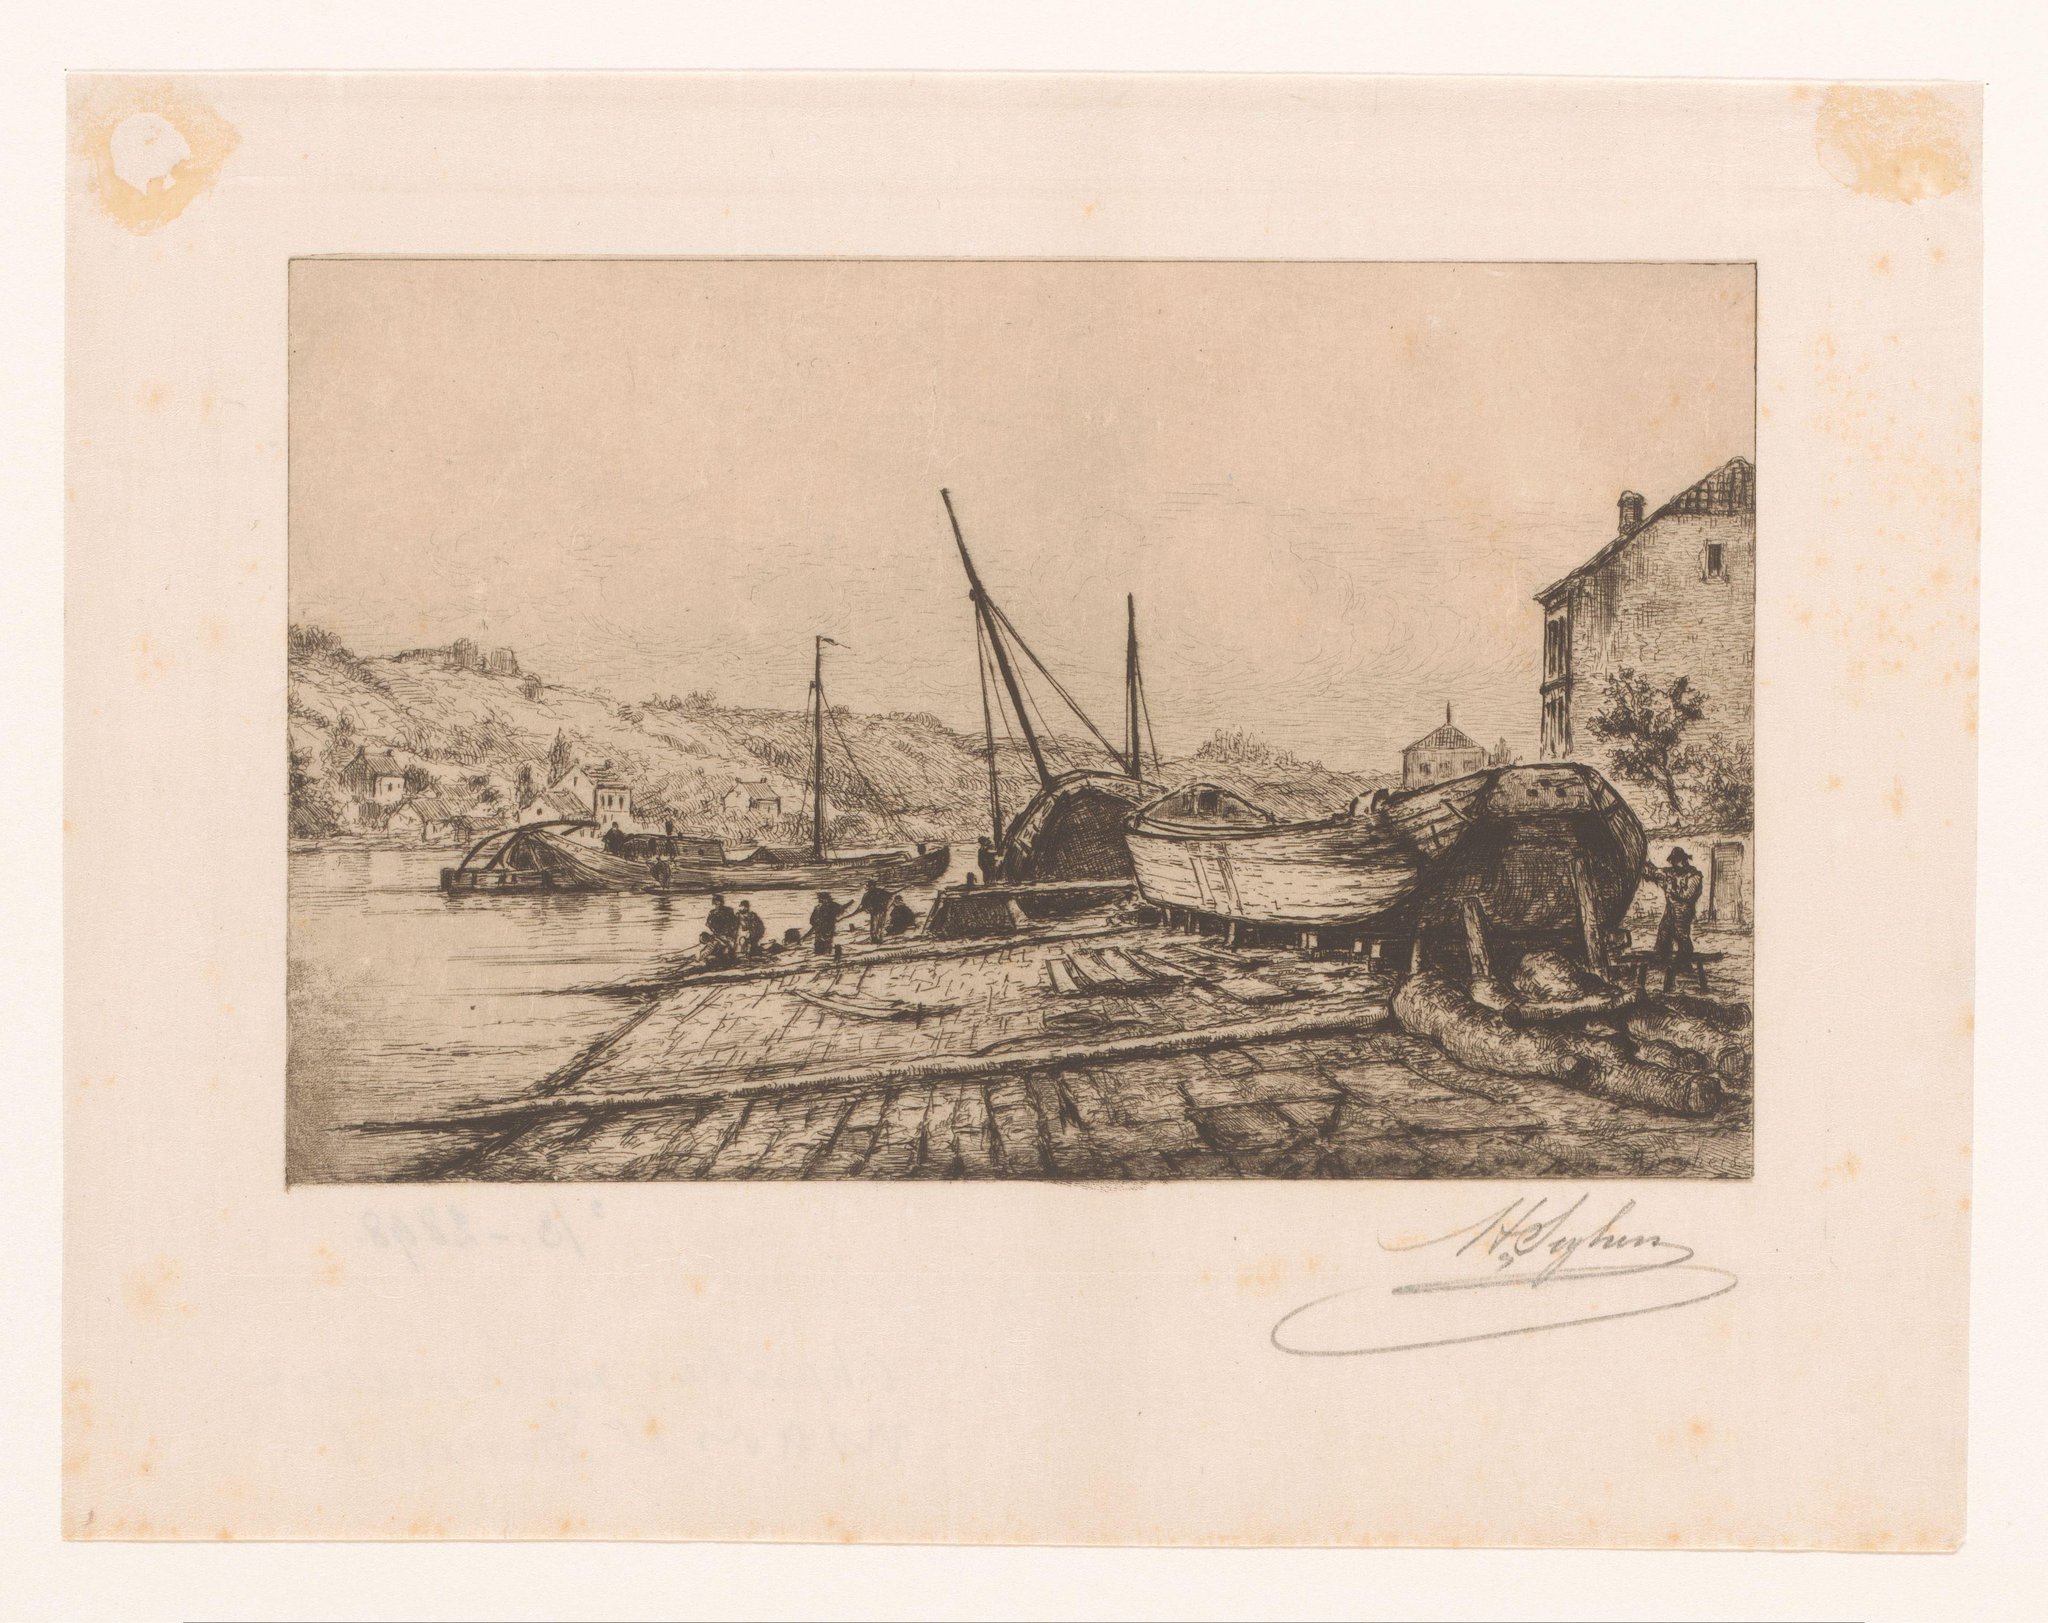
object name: print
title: Scheepstimmerwerf aan de Maas tegenover Dinant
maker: henri seghers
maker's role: draughtsman, painter, print maker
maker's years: 1848-1919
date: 1880-1913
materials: paper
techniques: drypoint, etching, intaglio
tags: river, ships, boats on land, beached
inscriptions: collector's mark: Lugt 2228, workshop stamp: ‘Antwerpsche Etsers 1880’